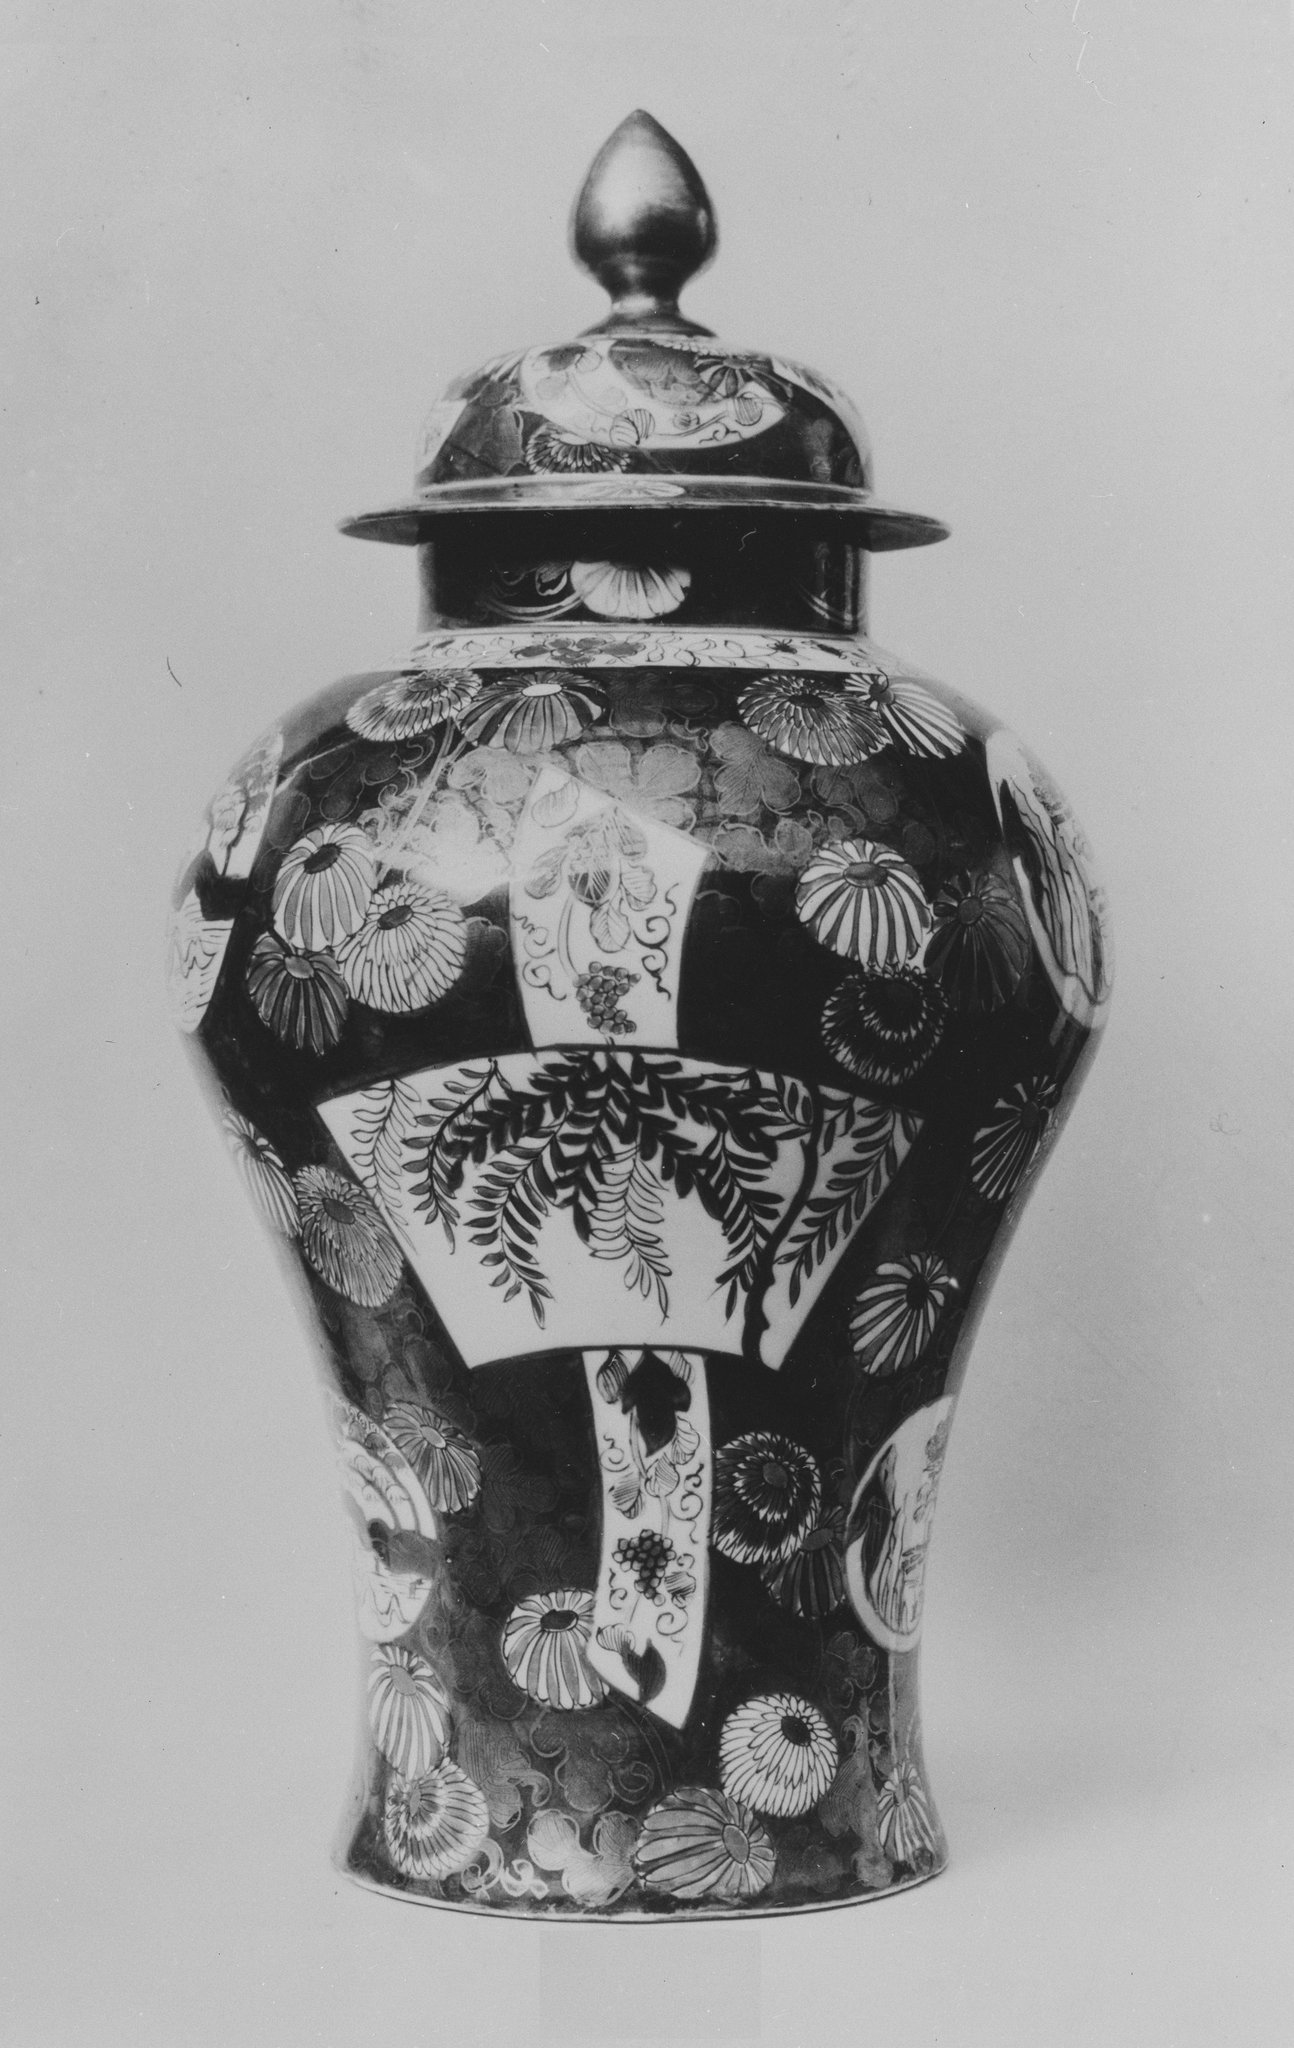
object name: jar with cover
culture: japanese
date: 1680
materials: enamel, porcelain